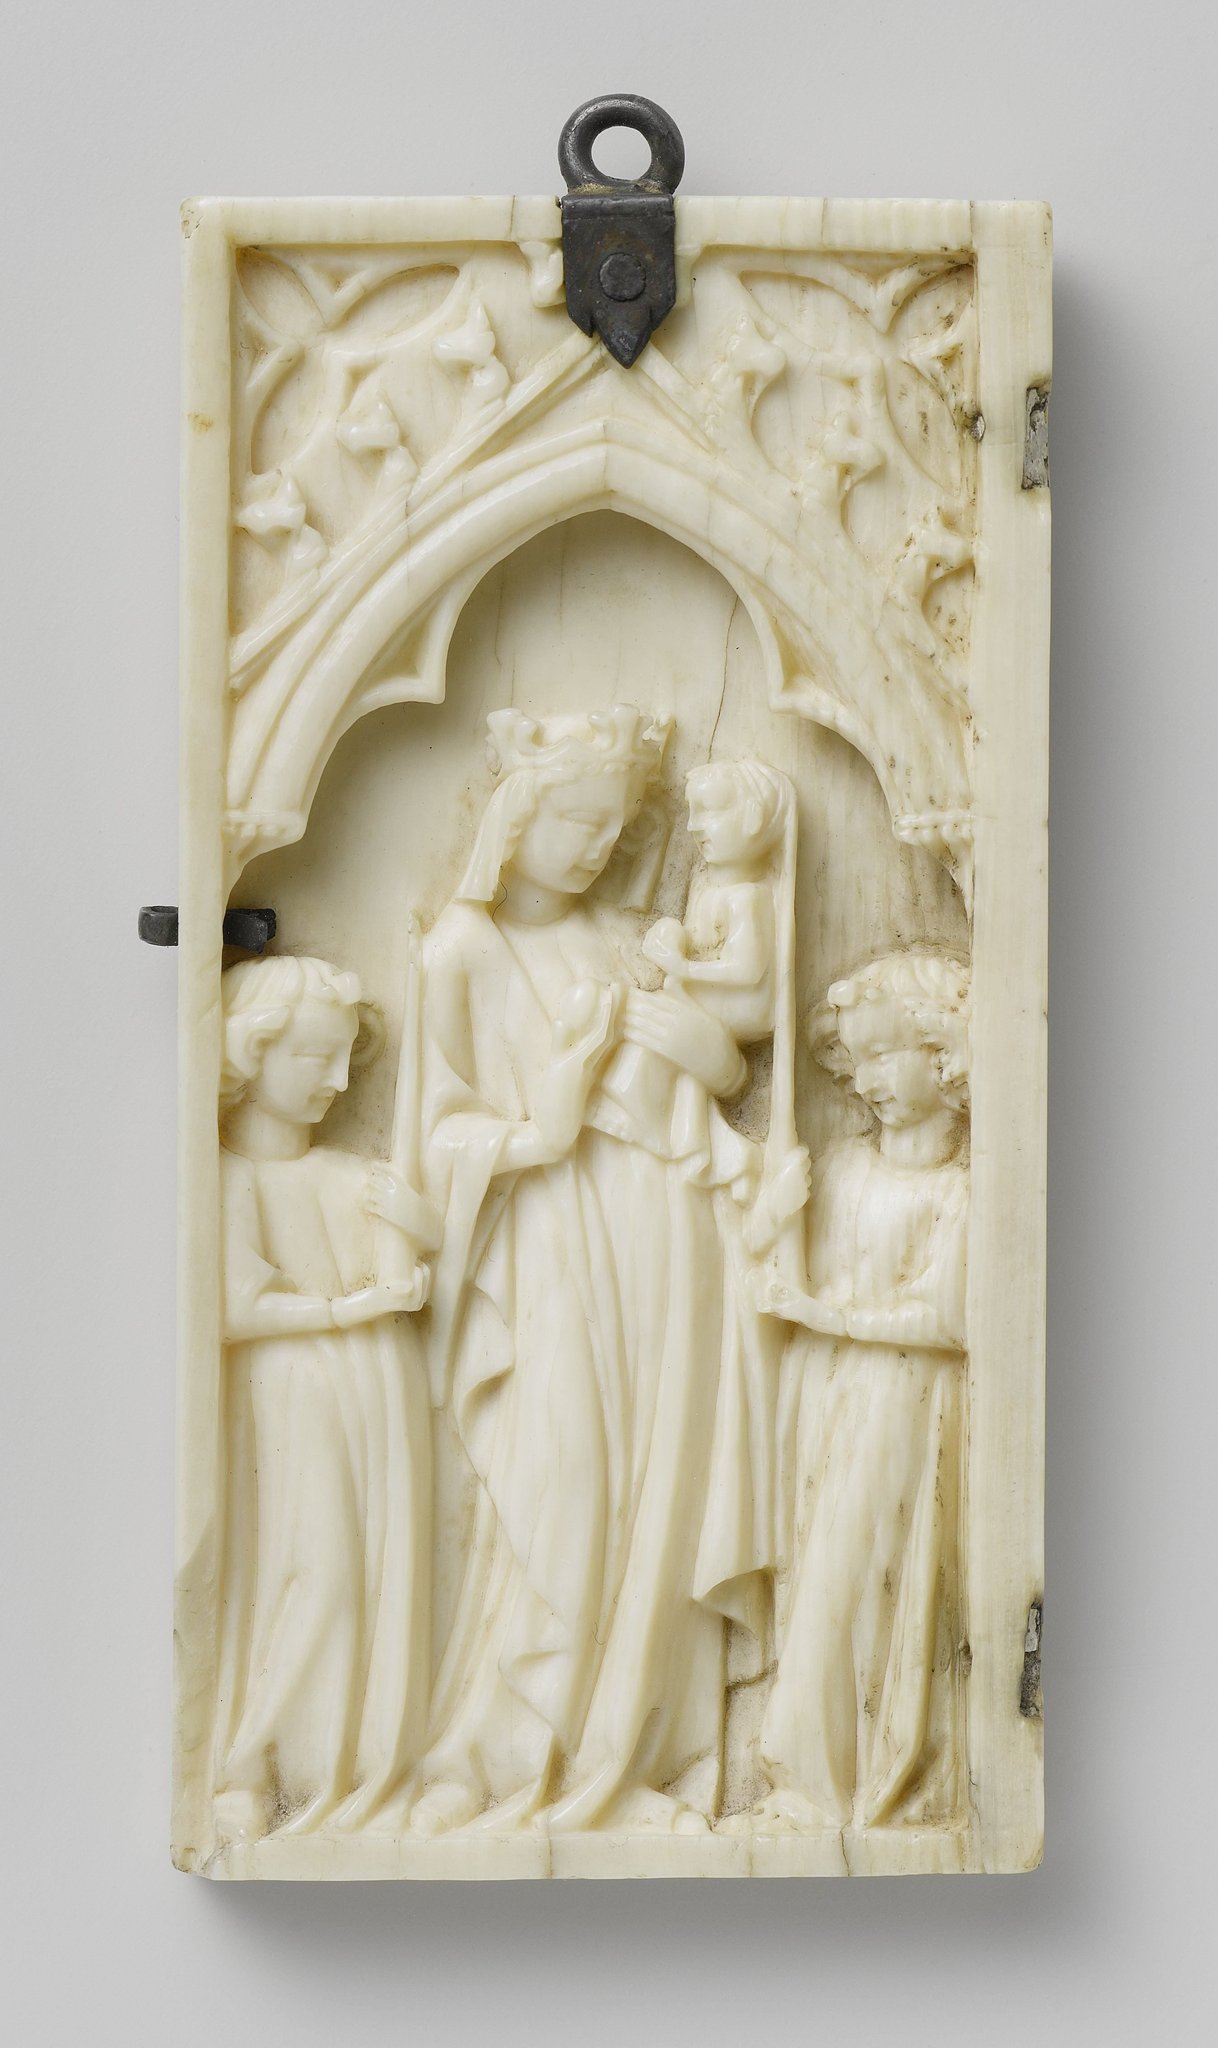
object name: relief sculpture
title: Left wing of a diptych, Virgin and Child flanked by Angels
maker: Anonymous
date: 1350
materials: copper, ivory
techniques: cutting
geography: ile-de-france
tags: mary standing (or half-length), the christ-child sitting on her arm (christ-child to mary's left), angel(s) with torch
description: Onder een gotische drielobbige spitsboog staat Maria tussen twee toortsdragende engelen met het kind op de linkerarm, dat met de linkerhand een appel en met de rechterhand zijn moeder's sluier vasthoudt. Maria heeft in de rechterhand een vrucht. Koperen oog bovenaan. Fragment van een slot.